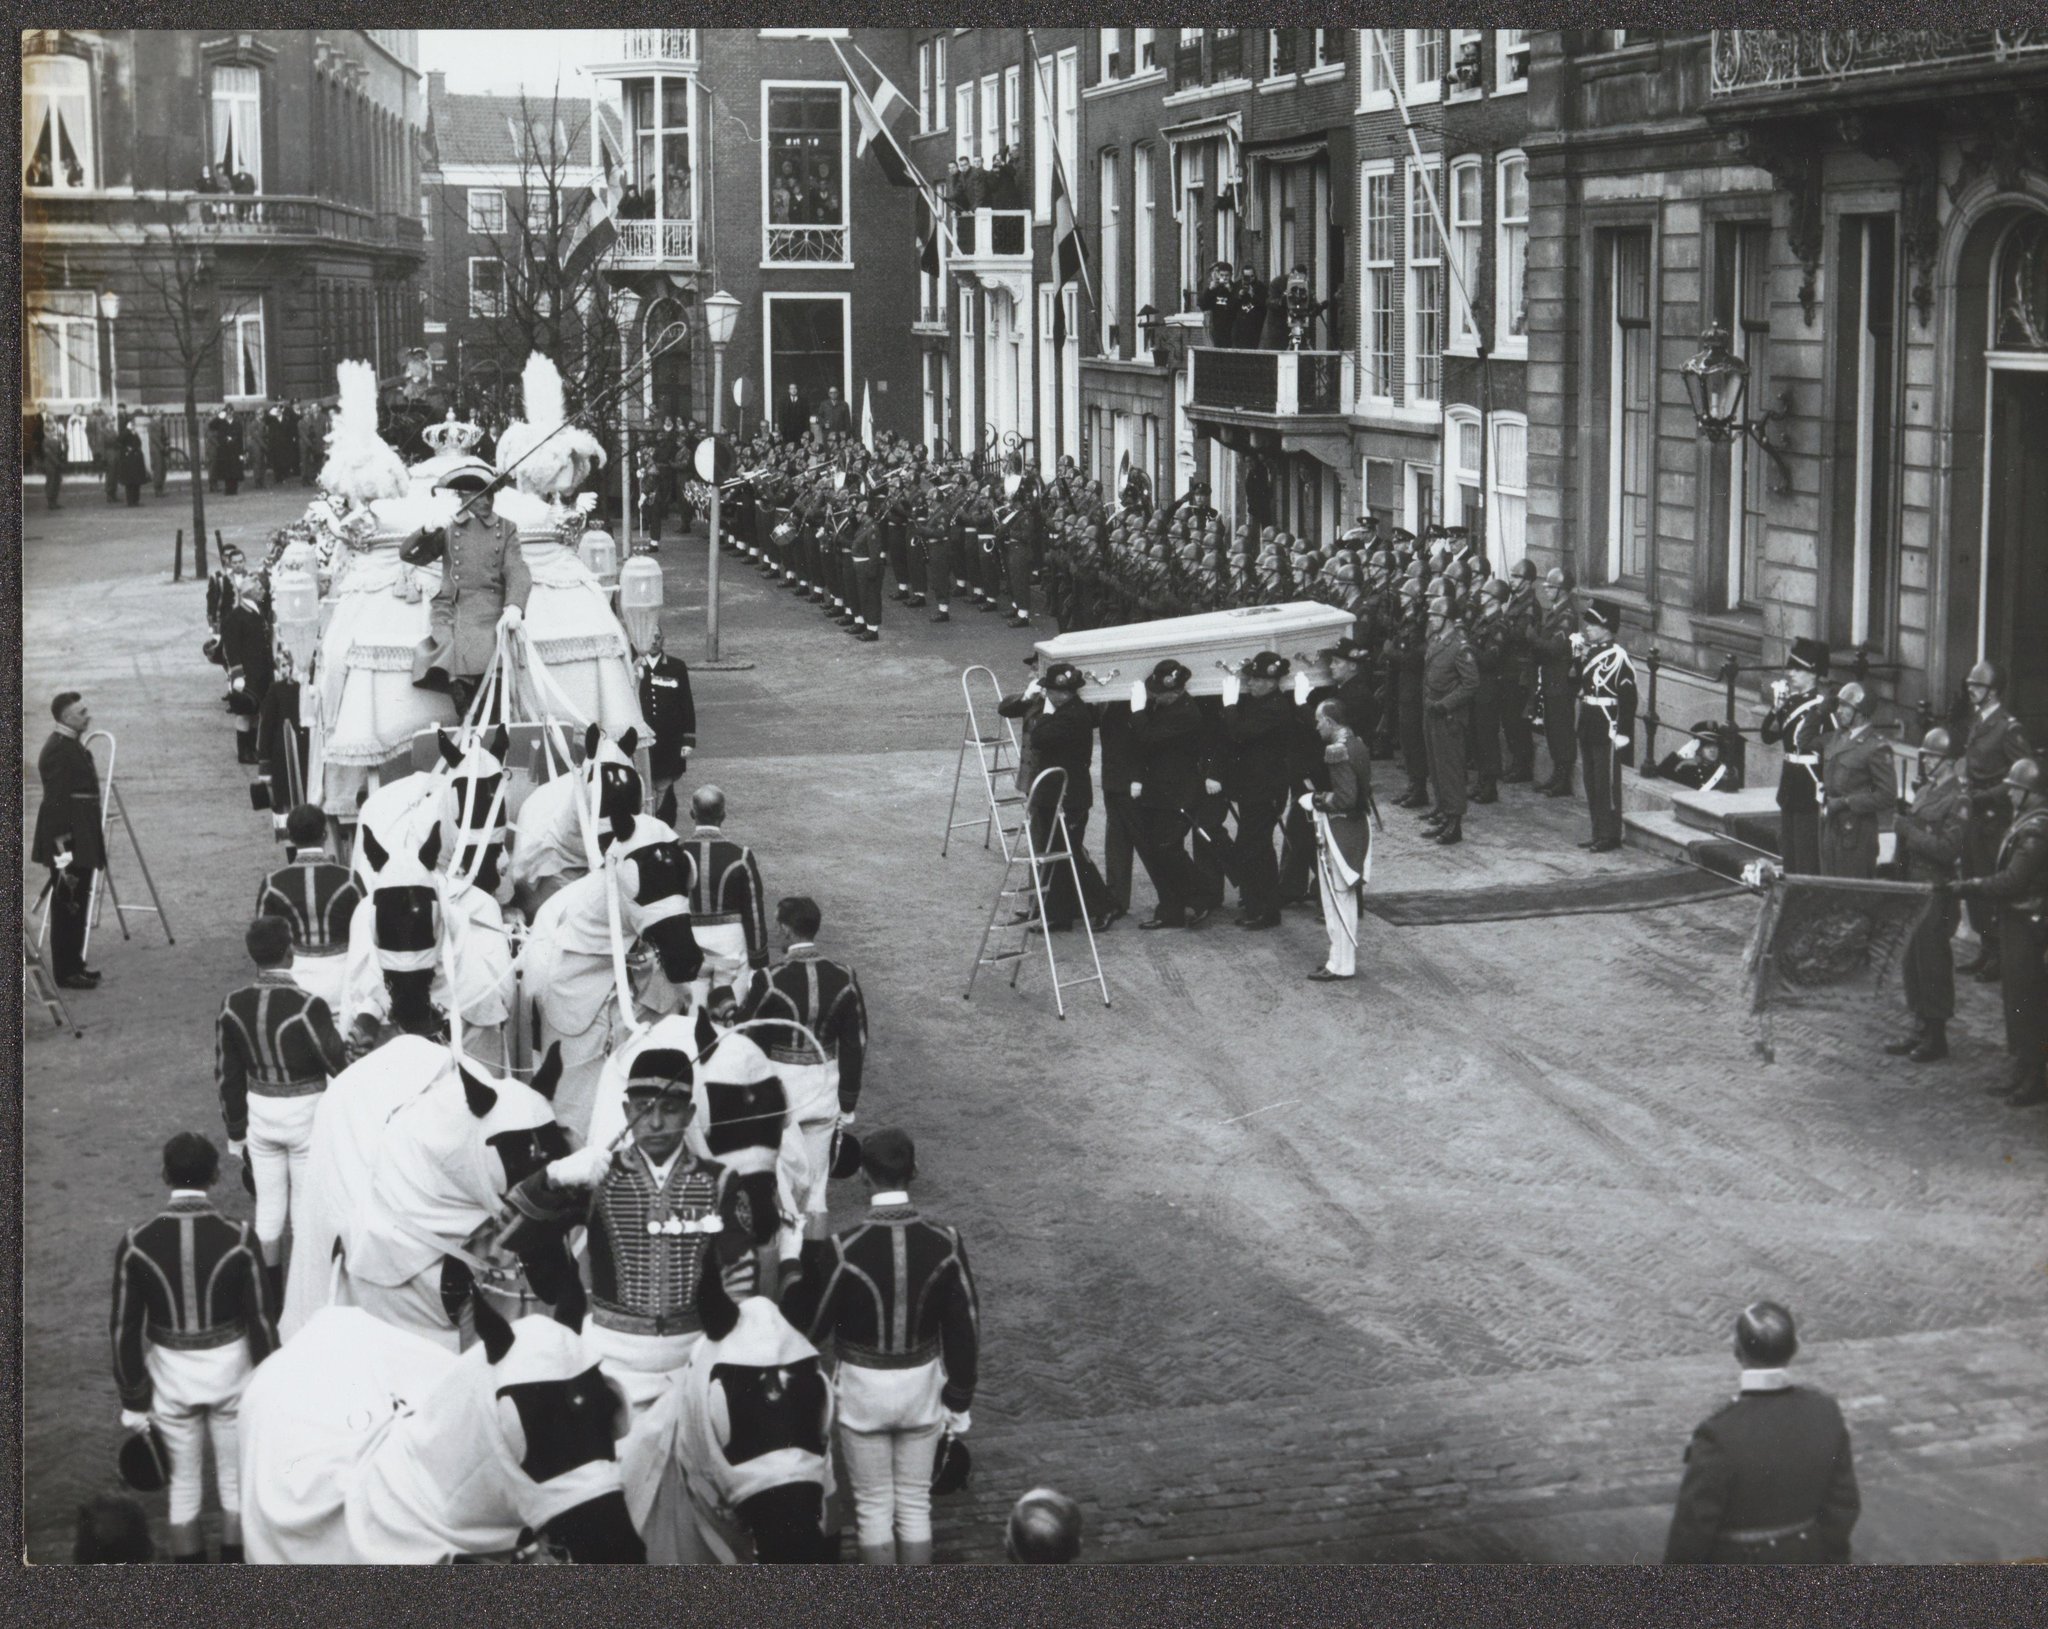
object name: photograph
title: Funeral of Princess Wilhelmina.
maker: Anonymous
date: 1962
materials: photographic support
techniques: gelatin silver print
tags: print maker, wilhelmina of the netherlands, public funeral, the hague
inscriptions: inscription: ‘Photo: The coffin is caried out from the Palace Lange Voorhout in The Hague by 8 royal Foresters Foto Anefo 7-12-1962’, inscription: ‘To-day the coffin with the mortal remains of HRH Princess Wilhelmina has been removed from the Palace Lange Voorhout at the Hague to the New Church at Delft, where Pr. Wilhelmina will be entombed’